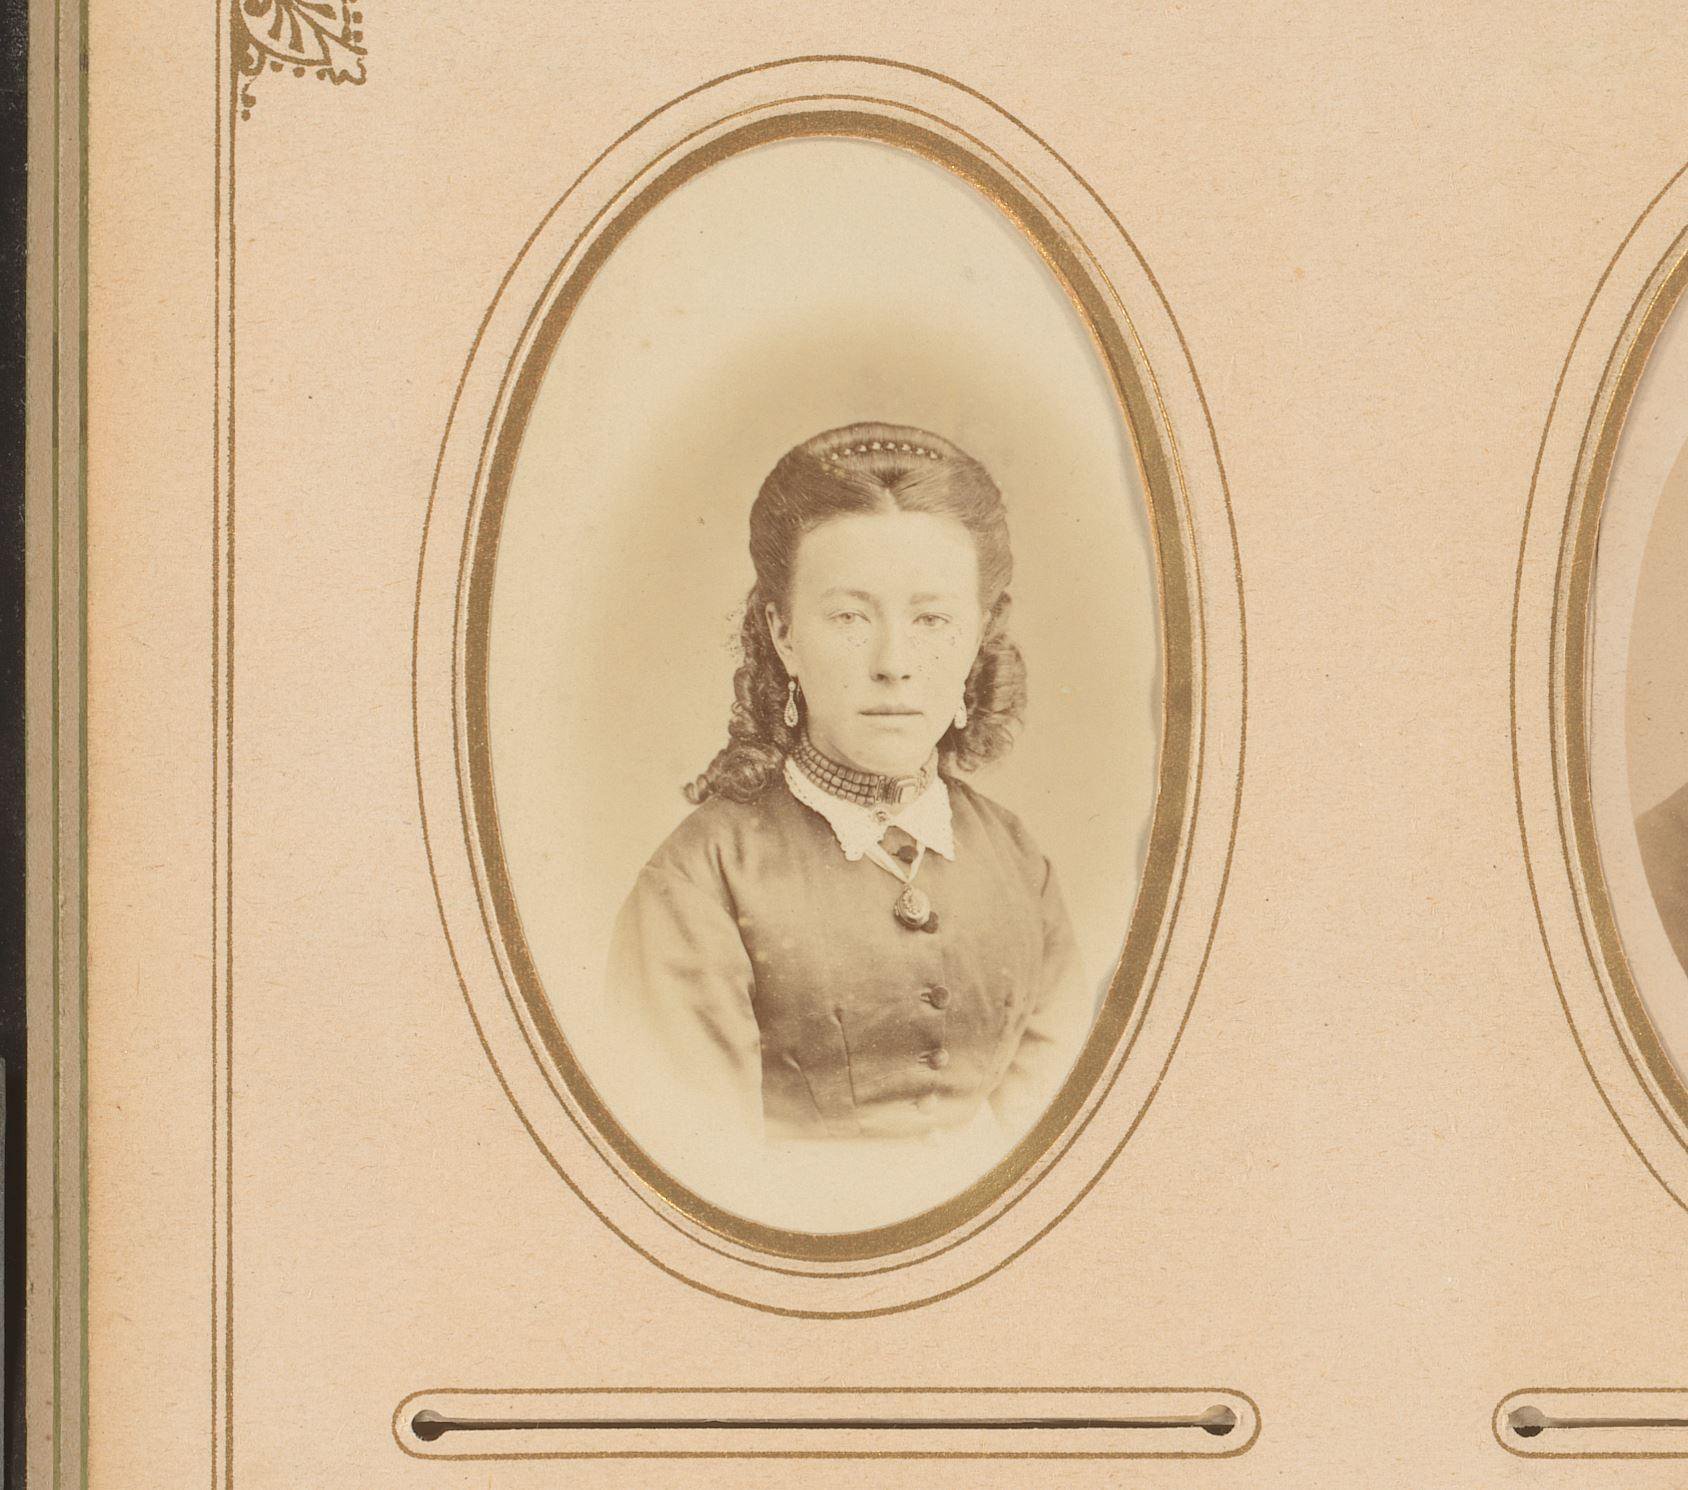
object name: photograph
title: Portret van een jonge vrouw met halsketting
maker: pieter siewers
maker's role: fotograaf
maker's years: 1819-1898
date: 1857-1894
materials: cardboard, photographic support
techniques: albumen print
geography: edam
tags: adolescent, young woman, maiden, historical persons - bb - woman, necklace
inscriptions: inscription: ‘P. SIEWERS/ PHOTOGRAAF/ EDAM.’